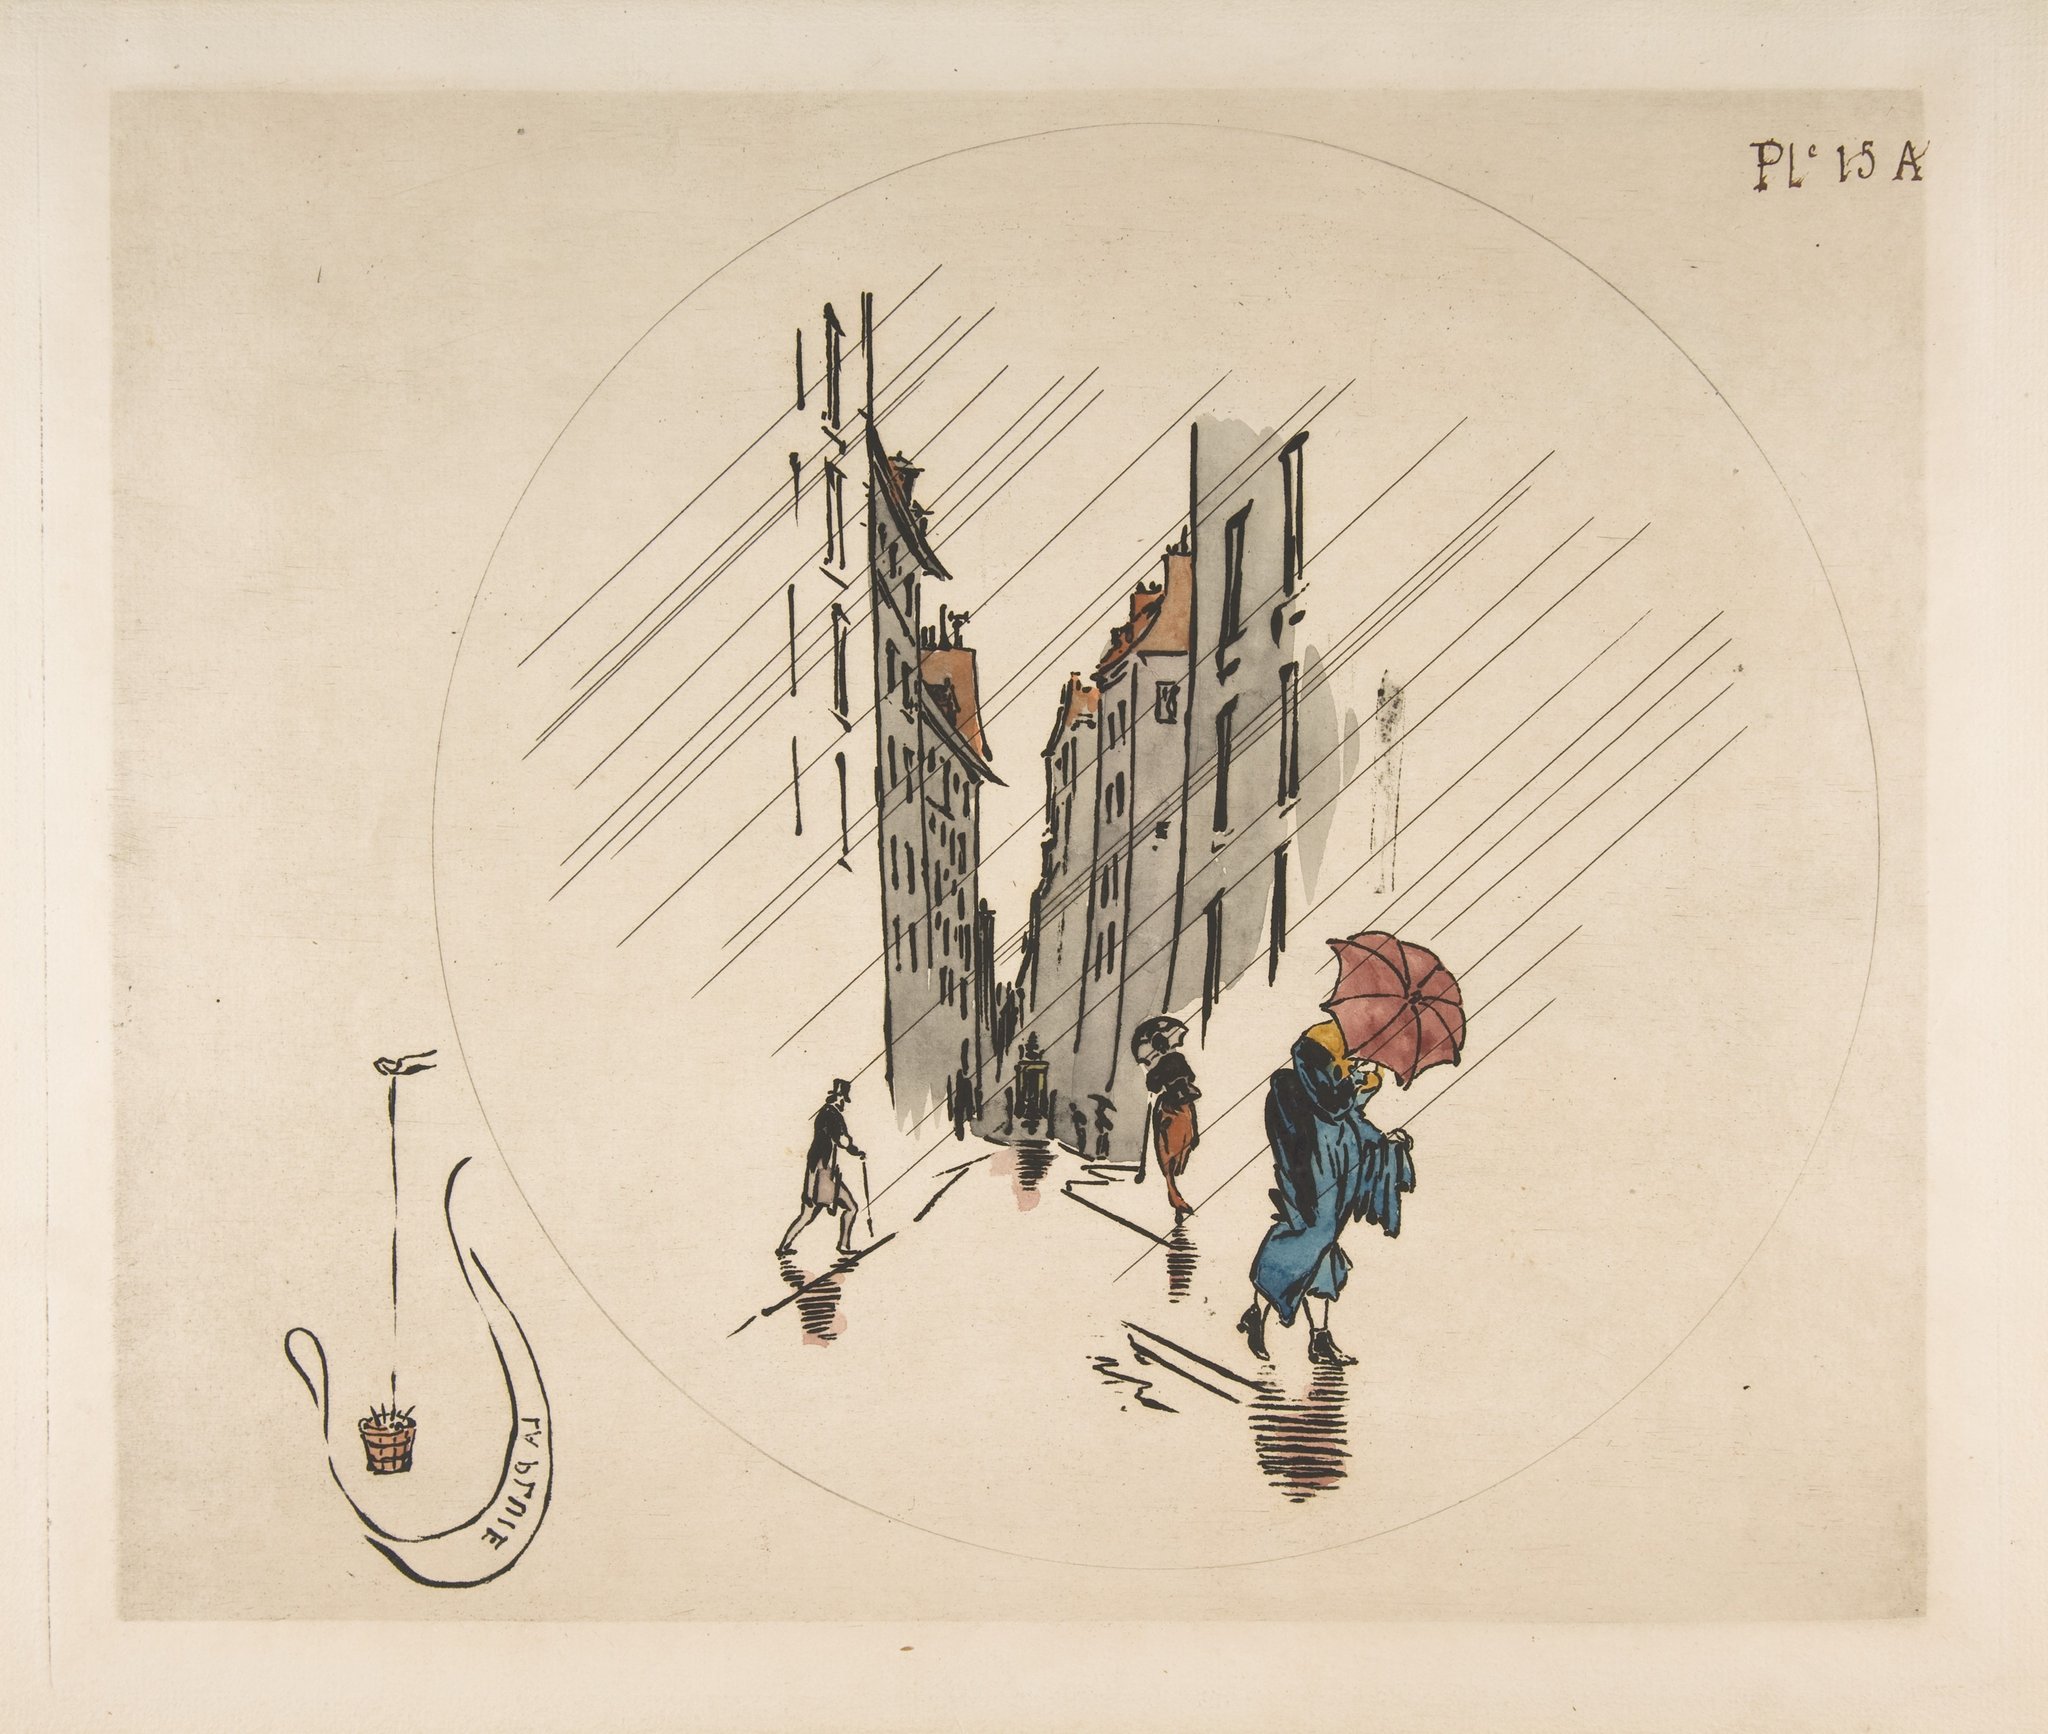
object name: print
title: Decoration for a Plate: Rain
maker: félix bracquemond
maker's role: artist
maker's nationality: french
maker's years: 1833-1914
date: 1870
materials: watercolor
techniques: etching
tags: human figures,buildings,rain